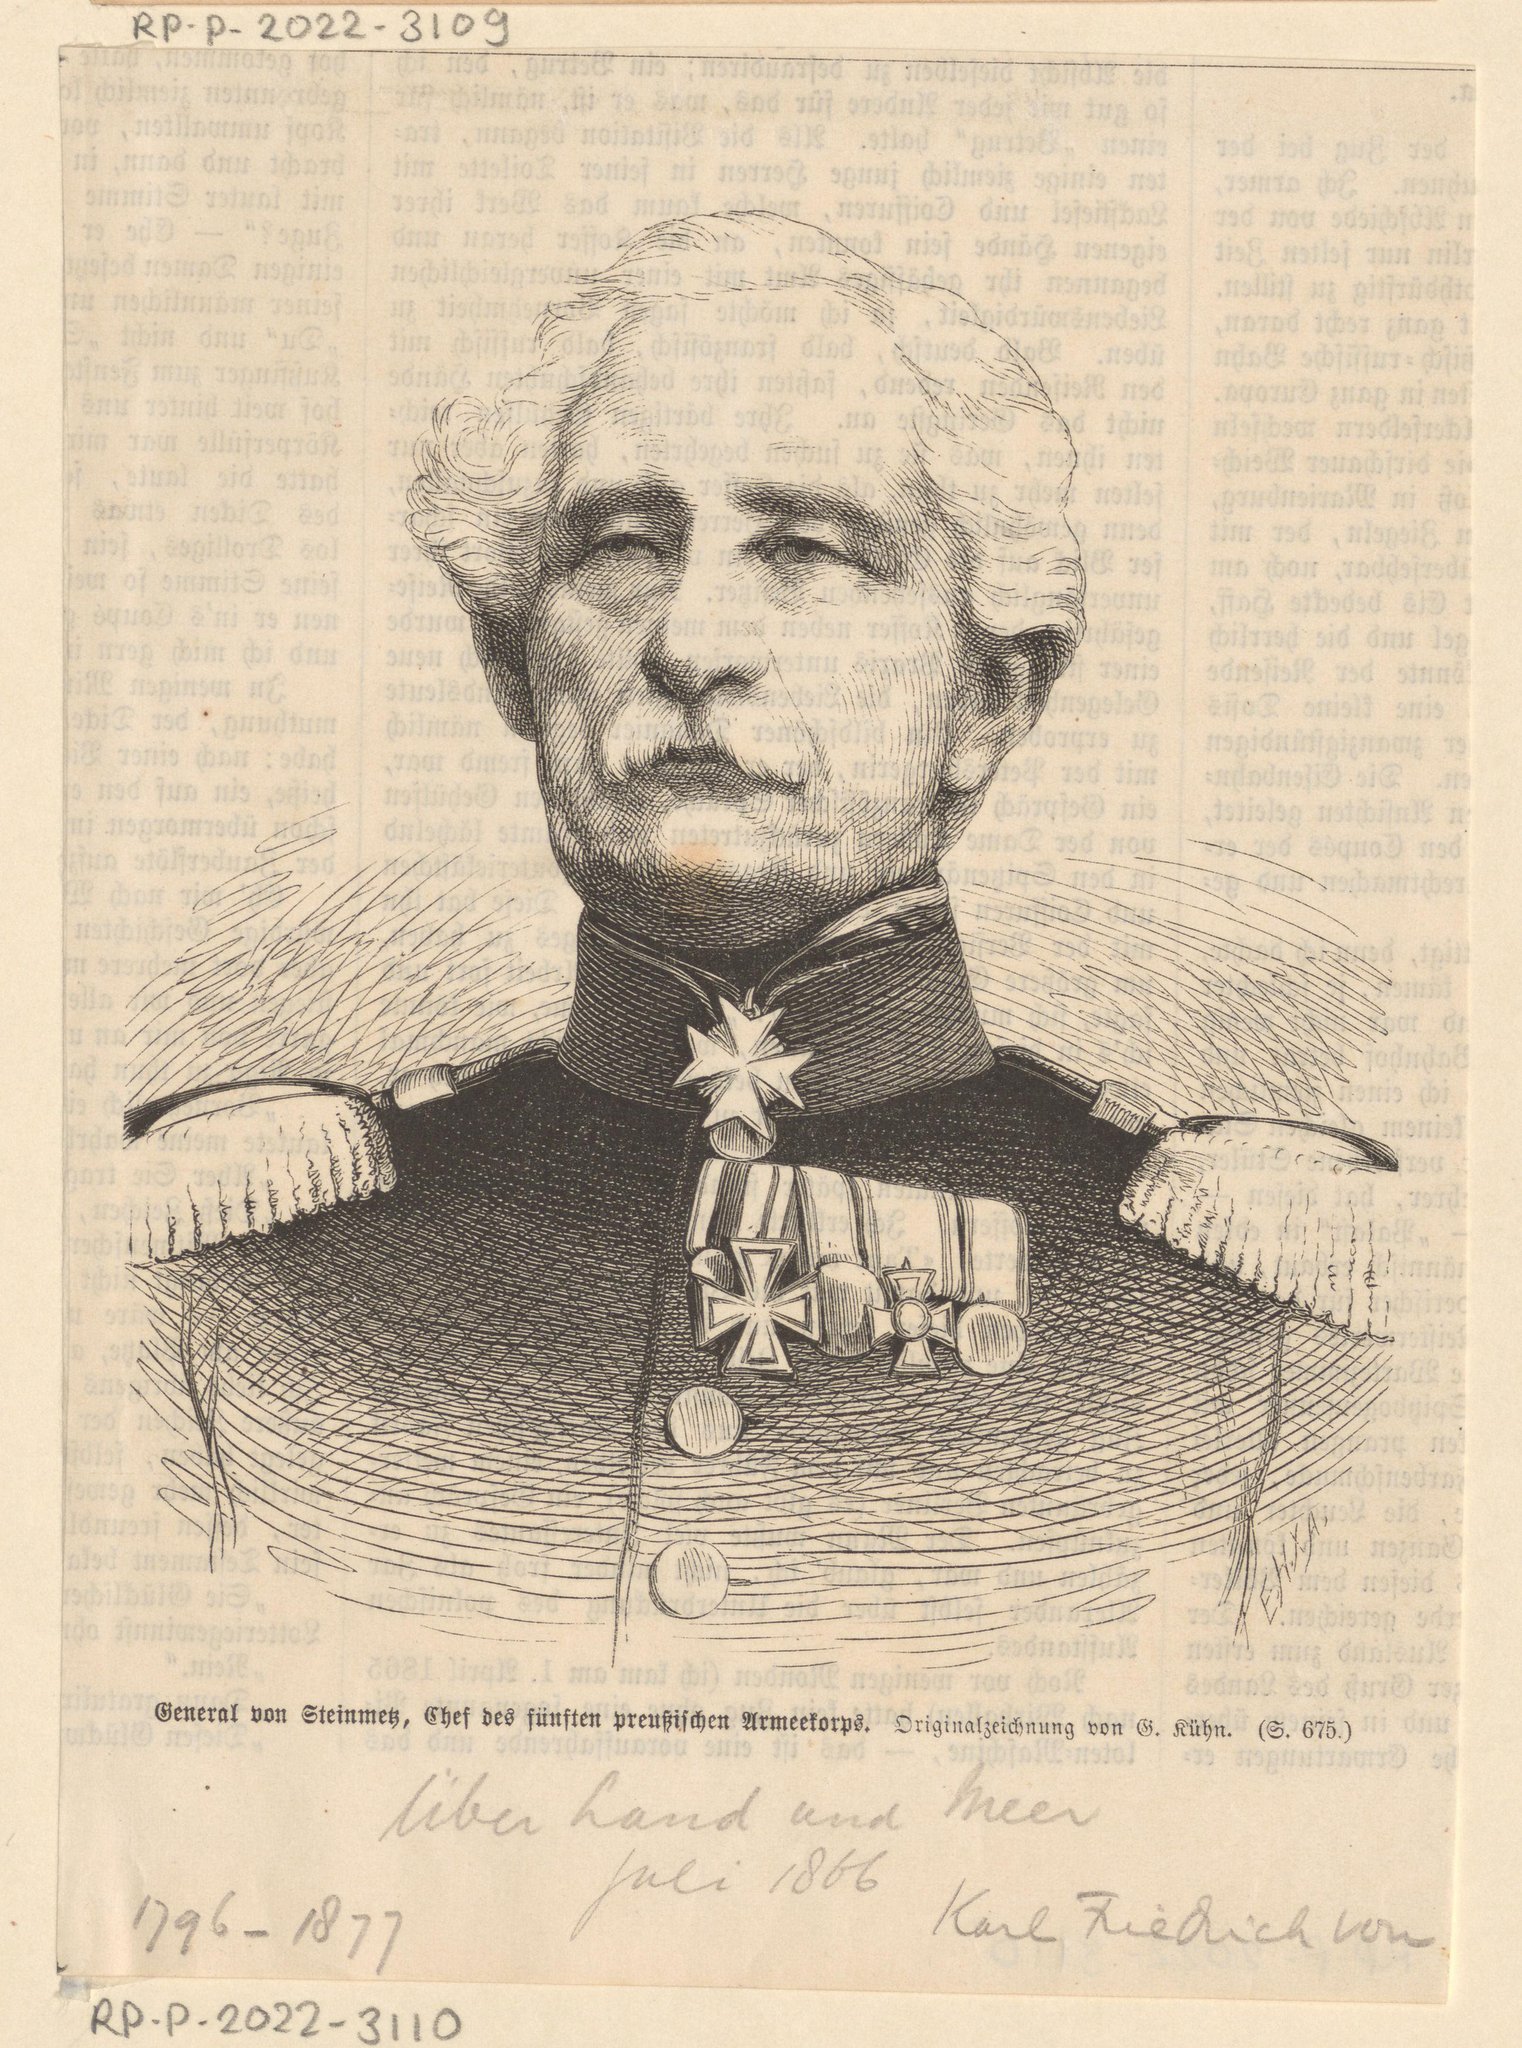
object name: print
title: Portret van Karl Friedrich von Steinmetz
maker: Anonymous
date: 1854-1899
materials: paper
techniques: letterpress printing, engraving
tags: poland, commander-in-chief, general, marshal, historical persons